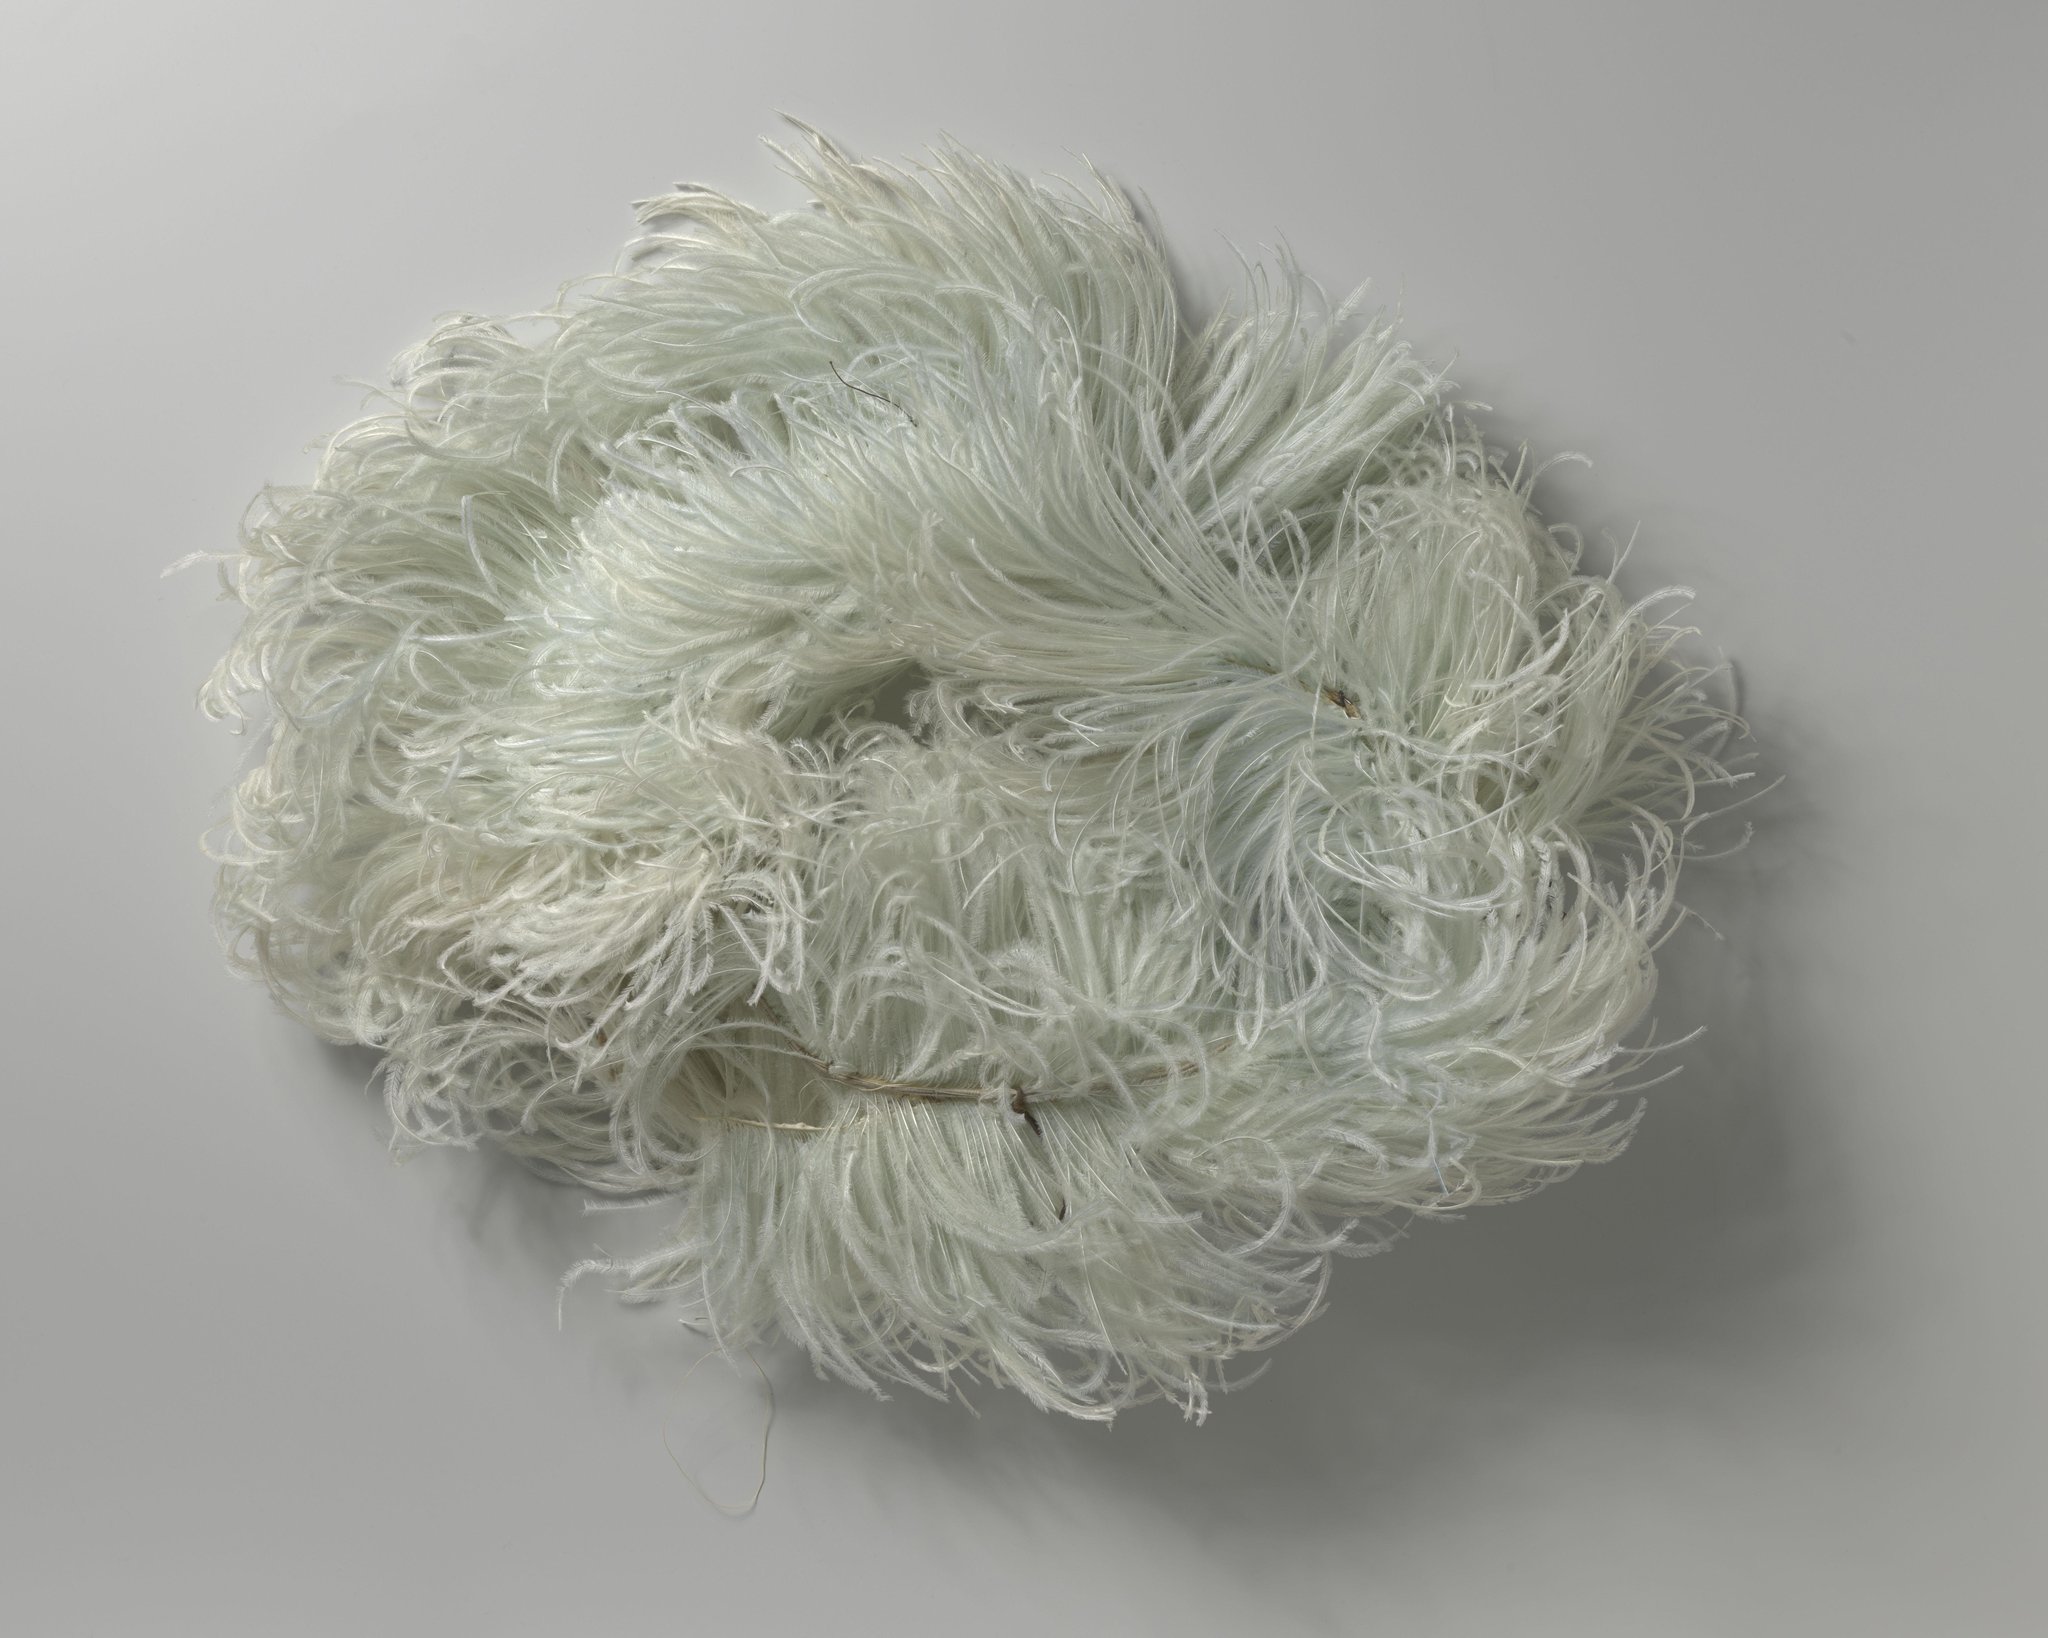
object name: womenswear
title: Struisveer, lichtblauw, rond model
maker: Anonymous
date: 1895-1915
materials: metal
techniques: painting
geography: western europe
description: Een grote struisveer in heel lichtblauw.